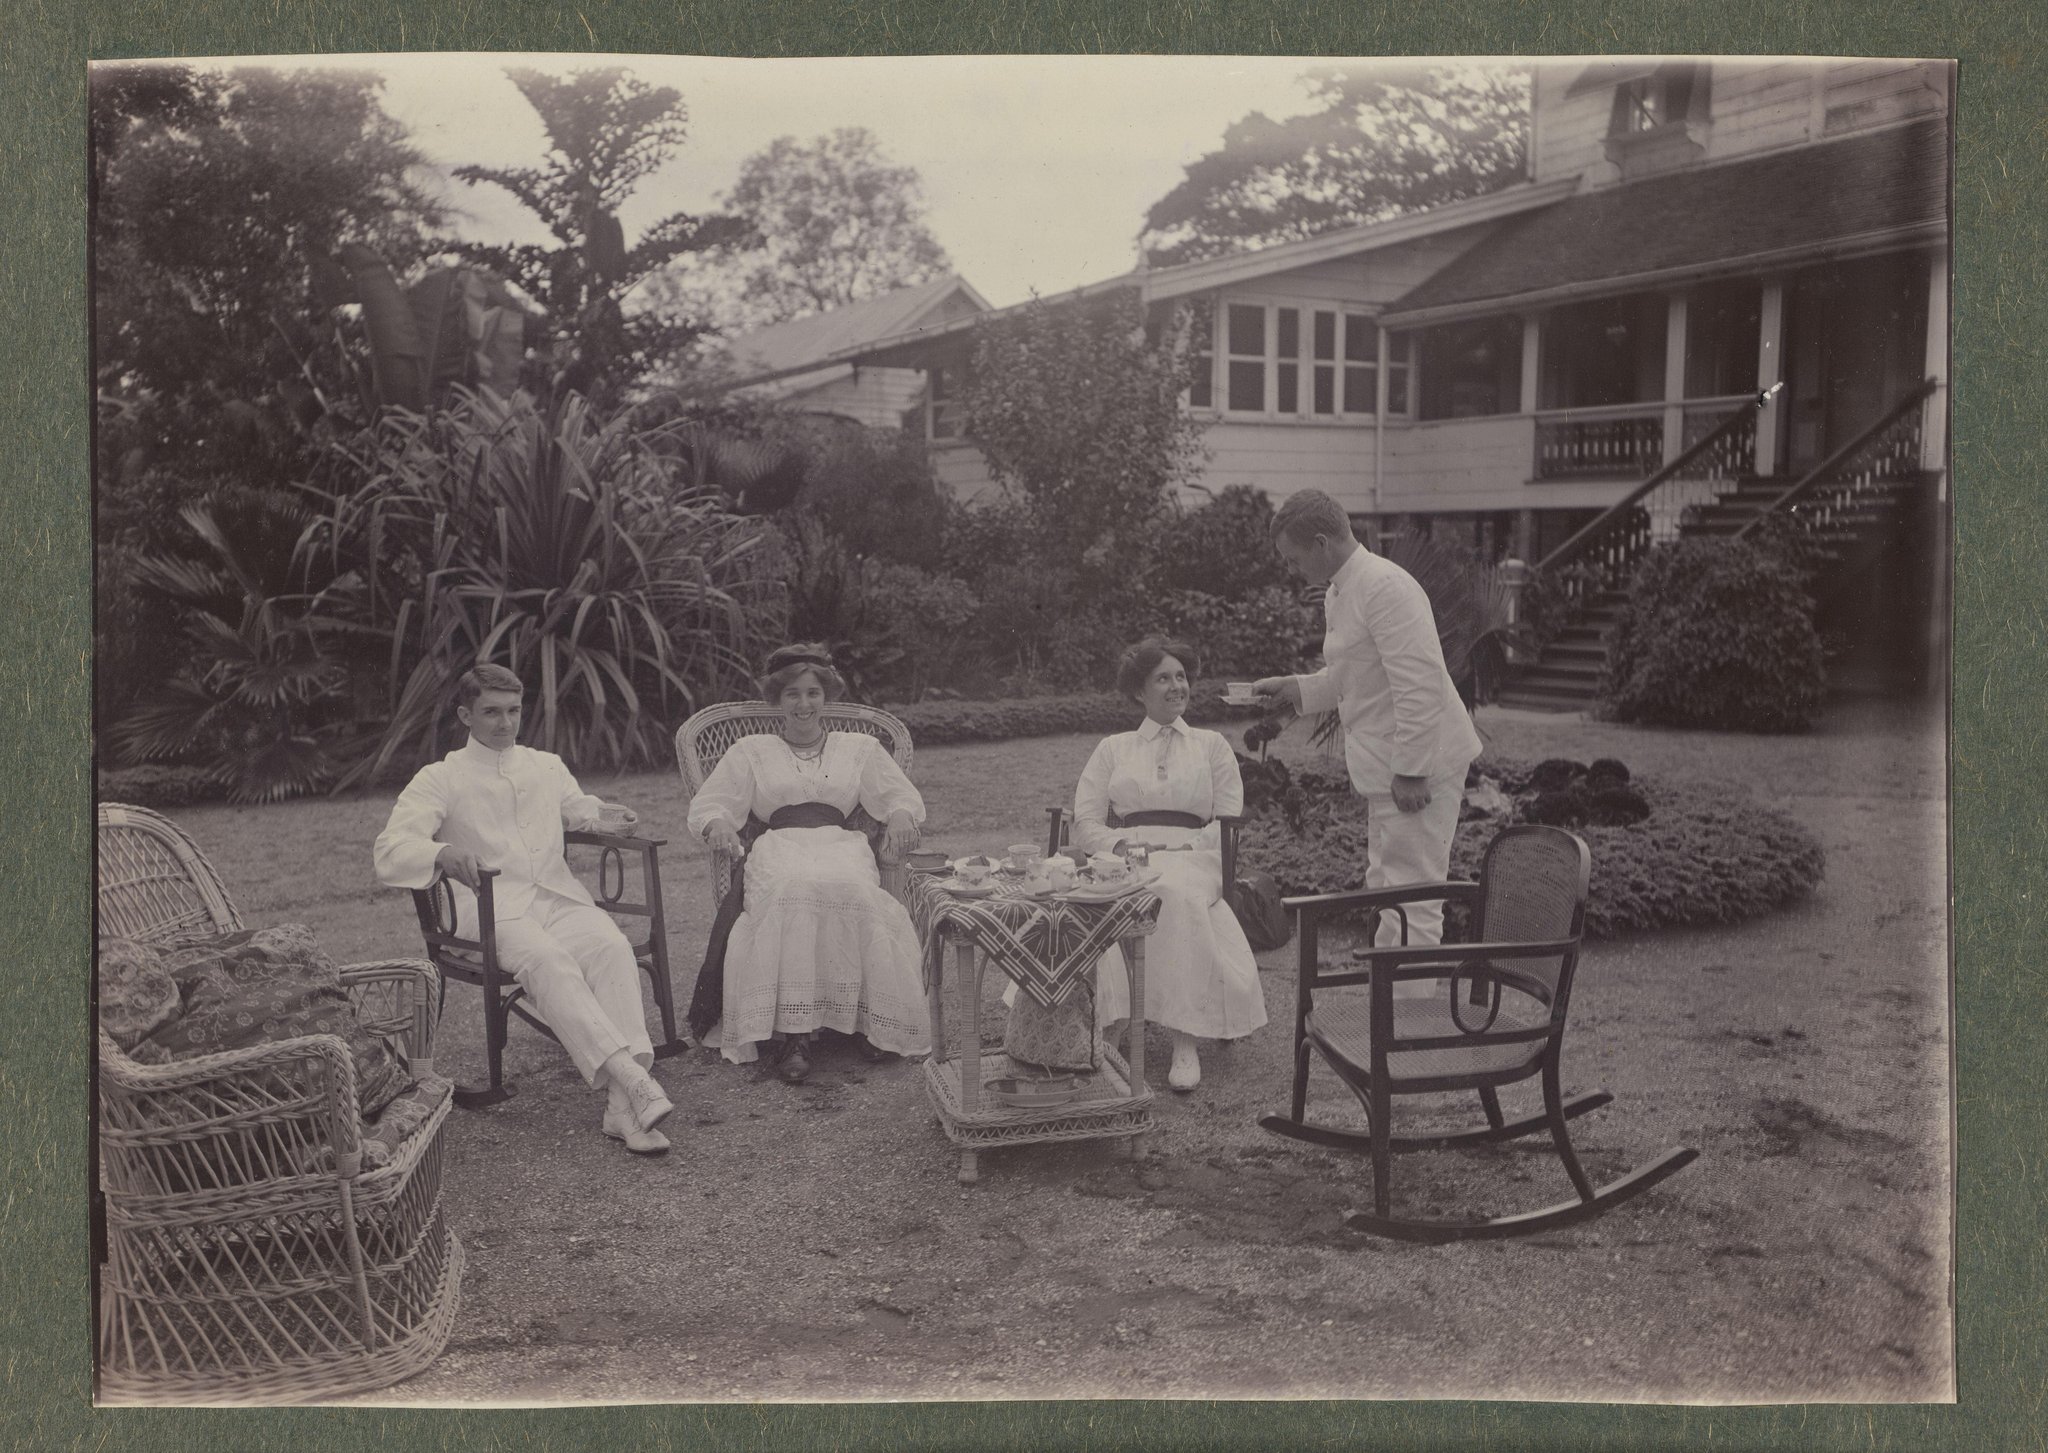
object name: photograph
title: In de tuin op Marienburg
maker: Anonymous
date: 1909-1910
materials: photographic support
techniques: collodion silver print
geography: suriname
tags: suriname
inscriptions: inscription: ‘Marienburg bij Willi in de tuin’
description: Twee mannen en twee vrouwen, waaronder Maria Gonggrijp, drinken thee in de tuin op Plantage Mariënburg. Onderdeel van het Lloyd fotoalbum van de familie Gonggrijp in de jaren 1909-1910.